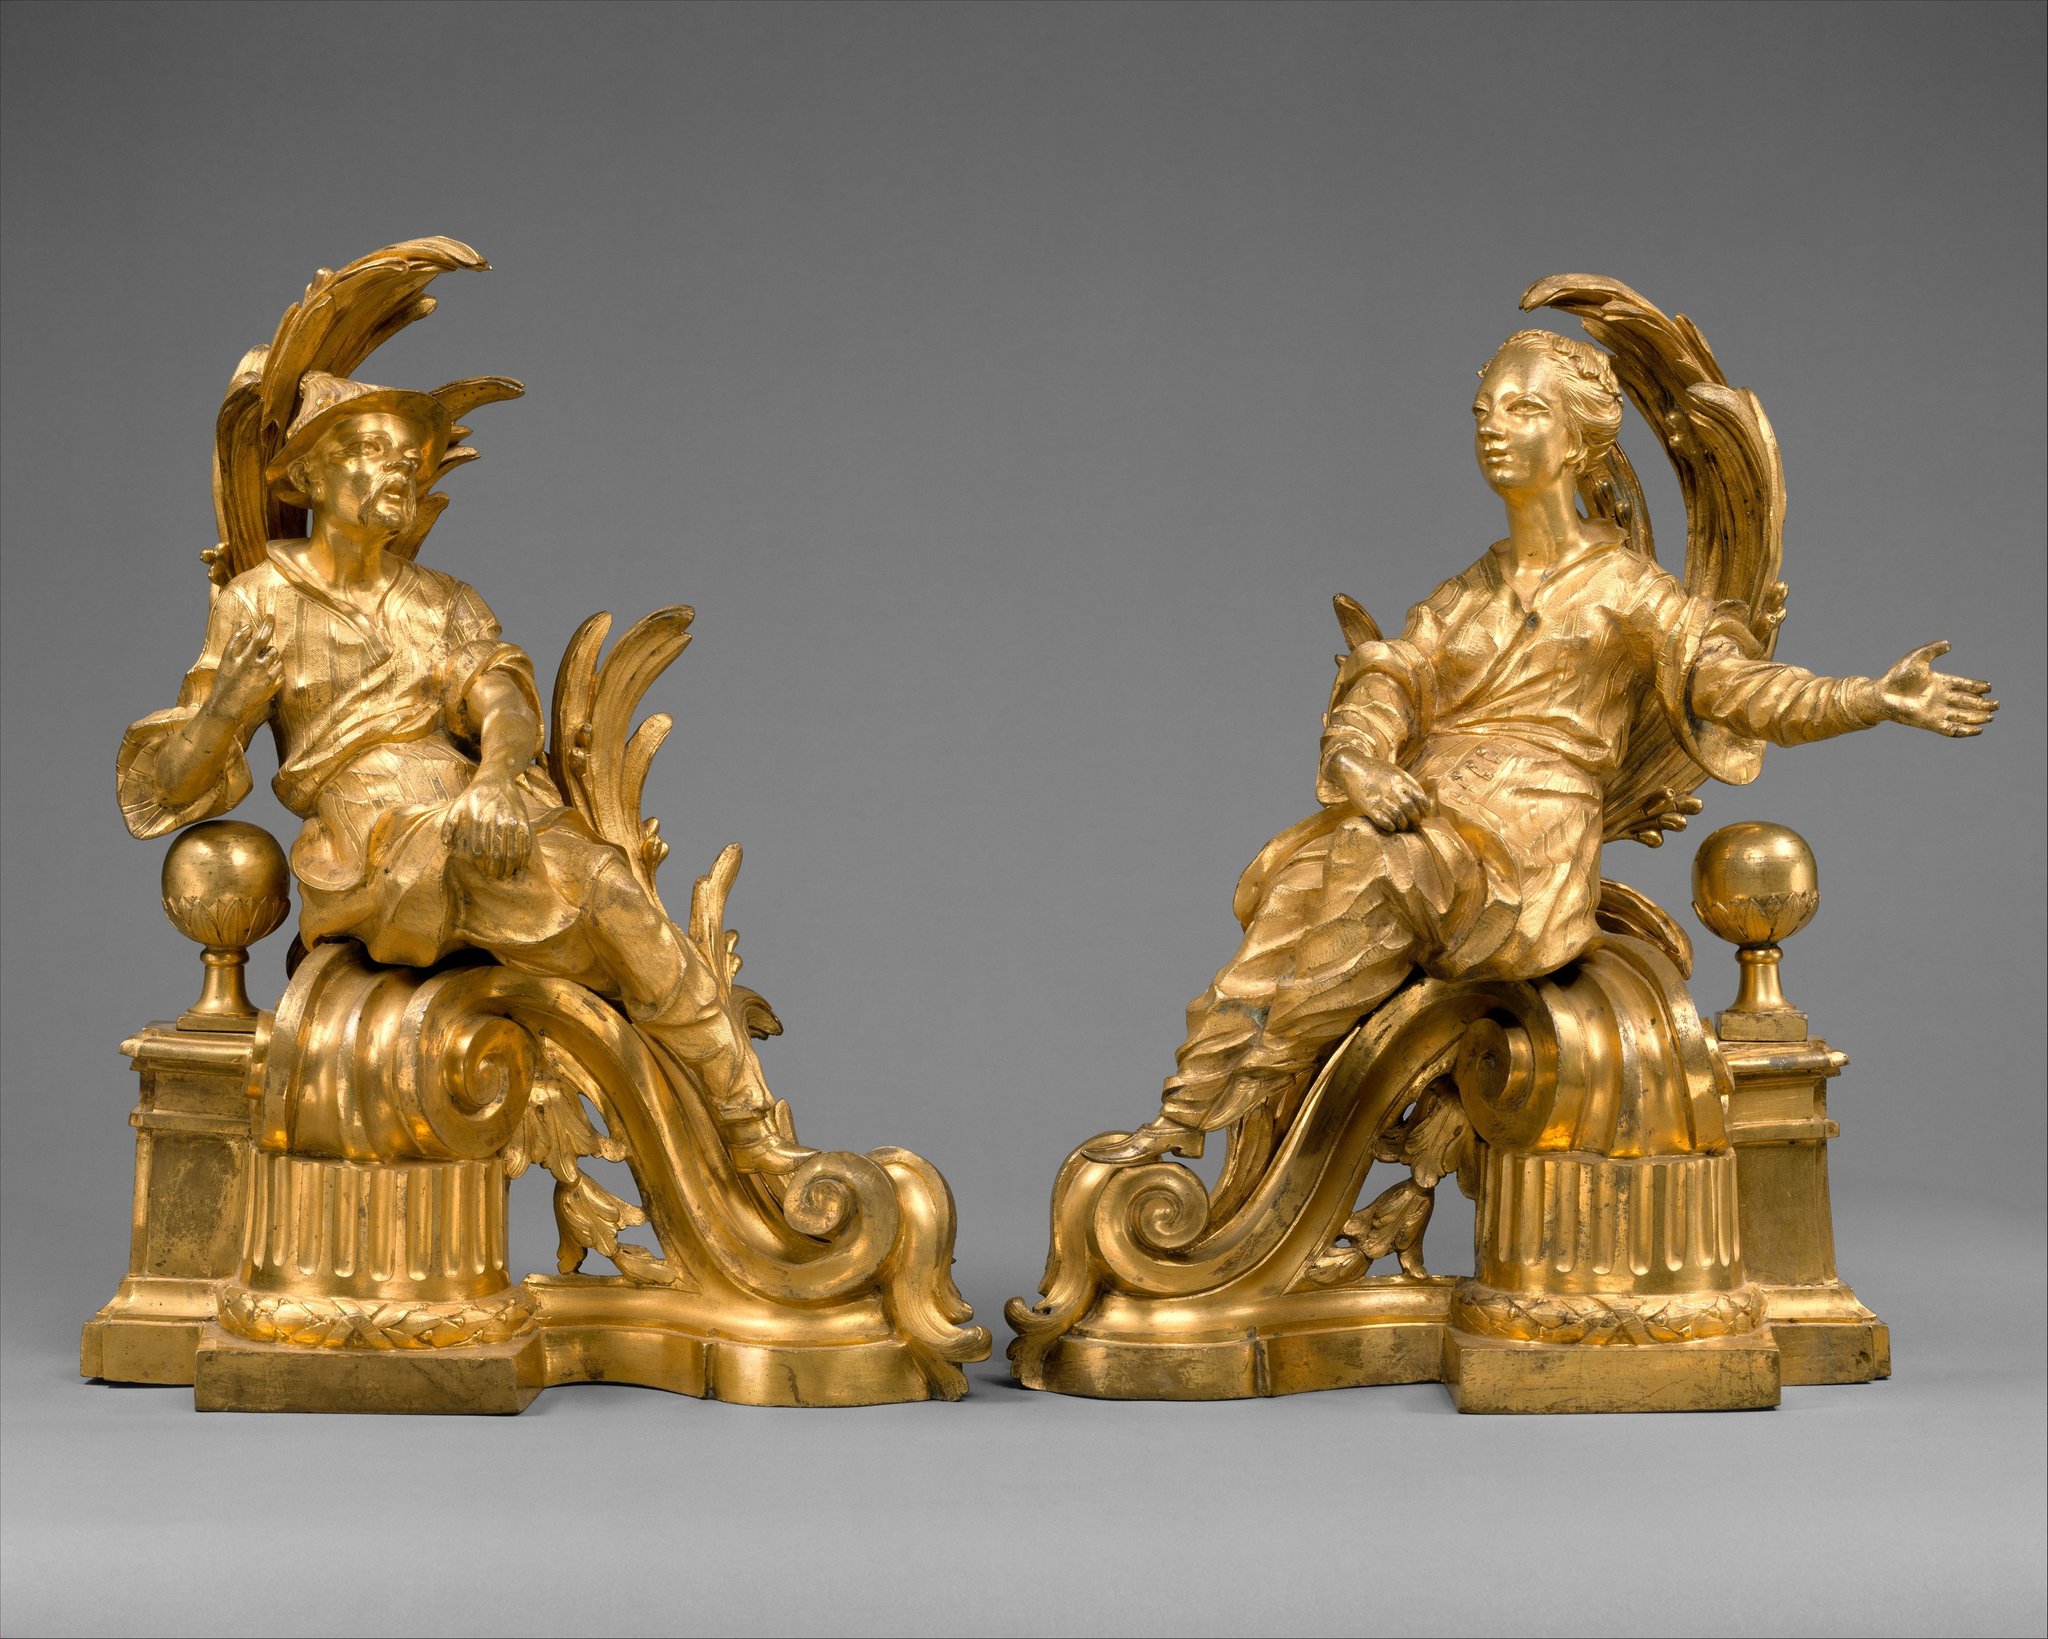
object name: firedog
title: Pair of firedogs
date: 1760-1770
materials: gilt bronze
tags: men,women